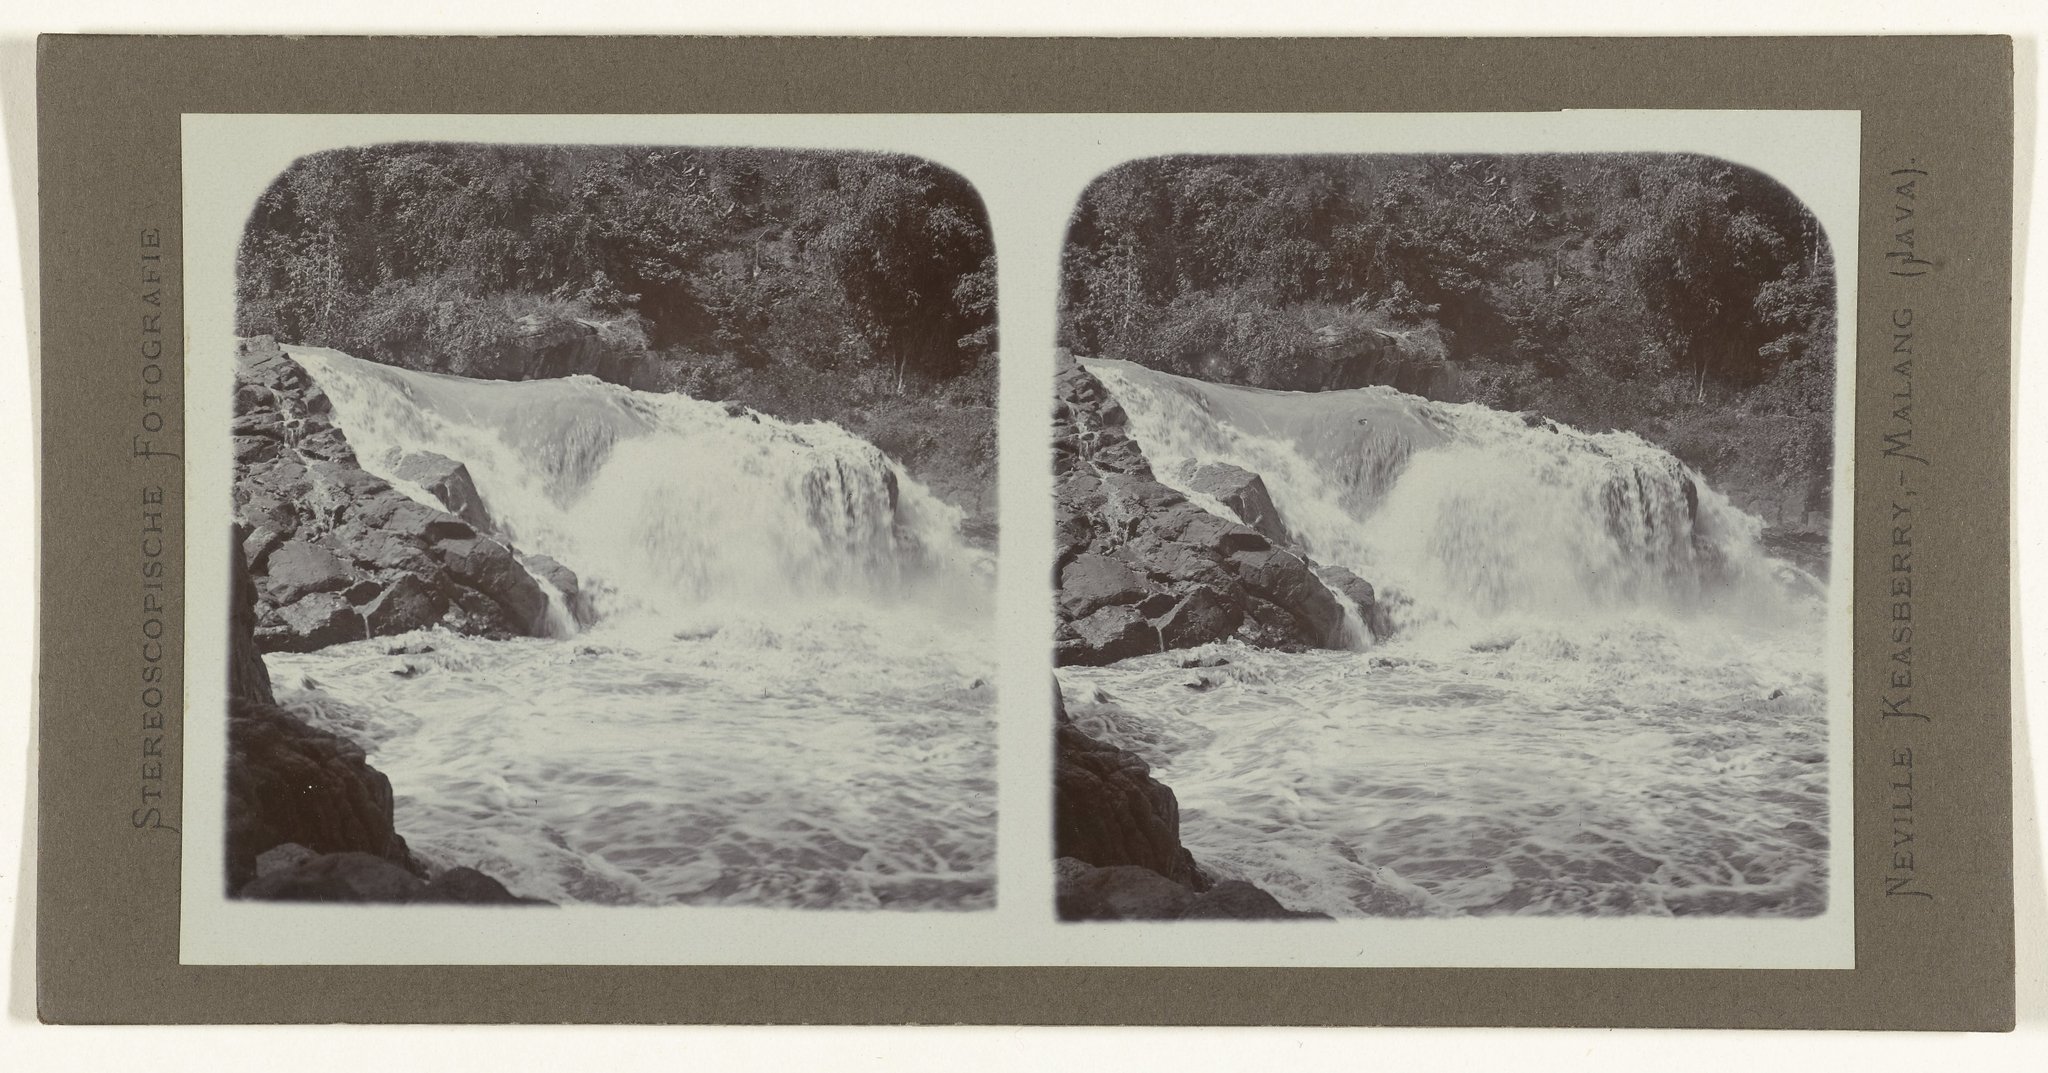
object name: stereograph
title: Waterval van de rivier Citarum in Lagadar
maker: neville keasberry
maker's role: fotograaf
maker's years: 1866-1944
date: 1900-1935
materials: cardboard, paper, photographic support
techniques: albumen print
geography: malang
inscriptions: inscription: ‘Stereoscopische Fotografie’, signature: ‘Neville Keasberry, Malang (Java)’, title: ‘S 3 No 34. De waterval van de Tjitaroem te Lagadar, Preanger.’